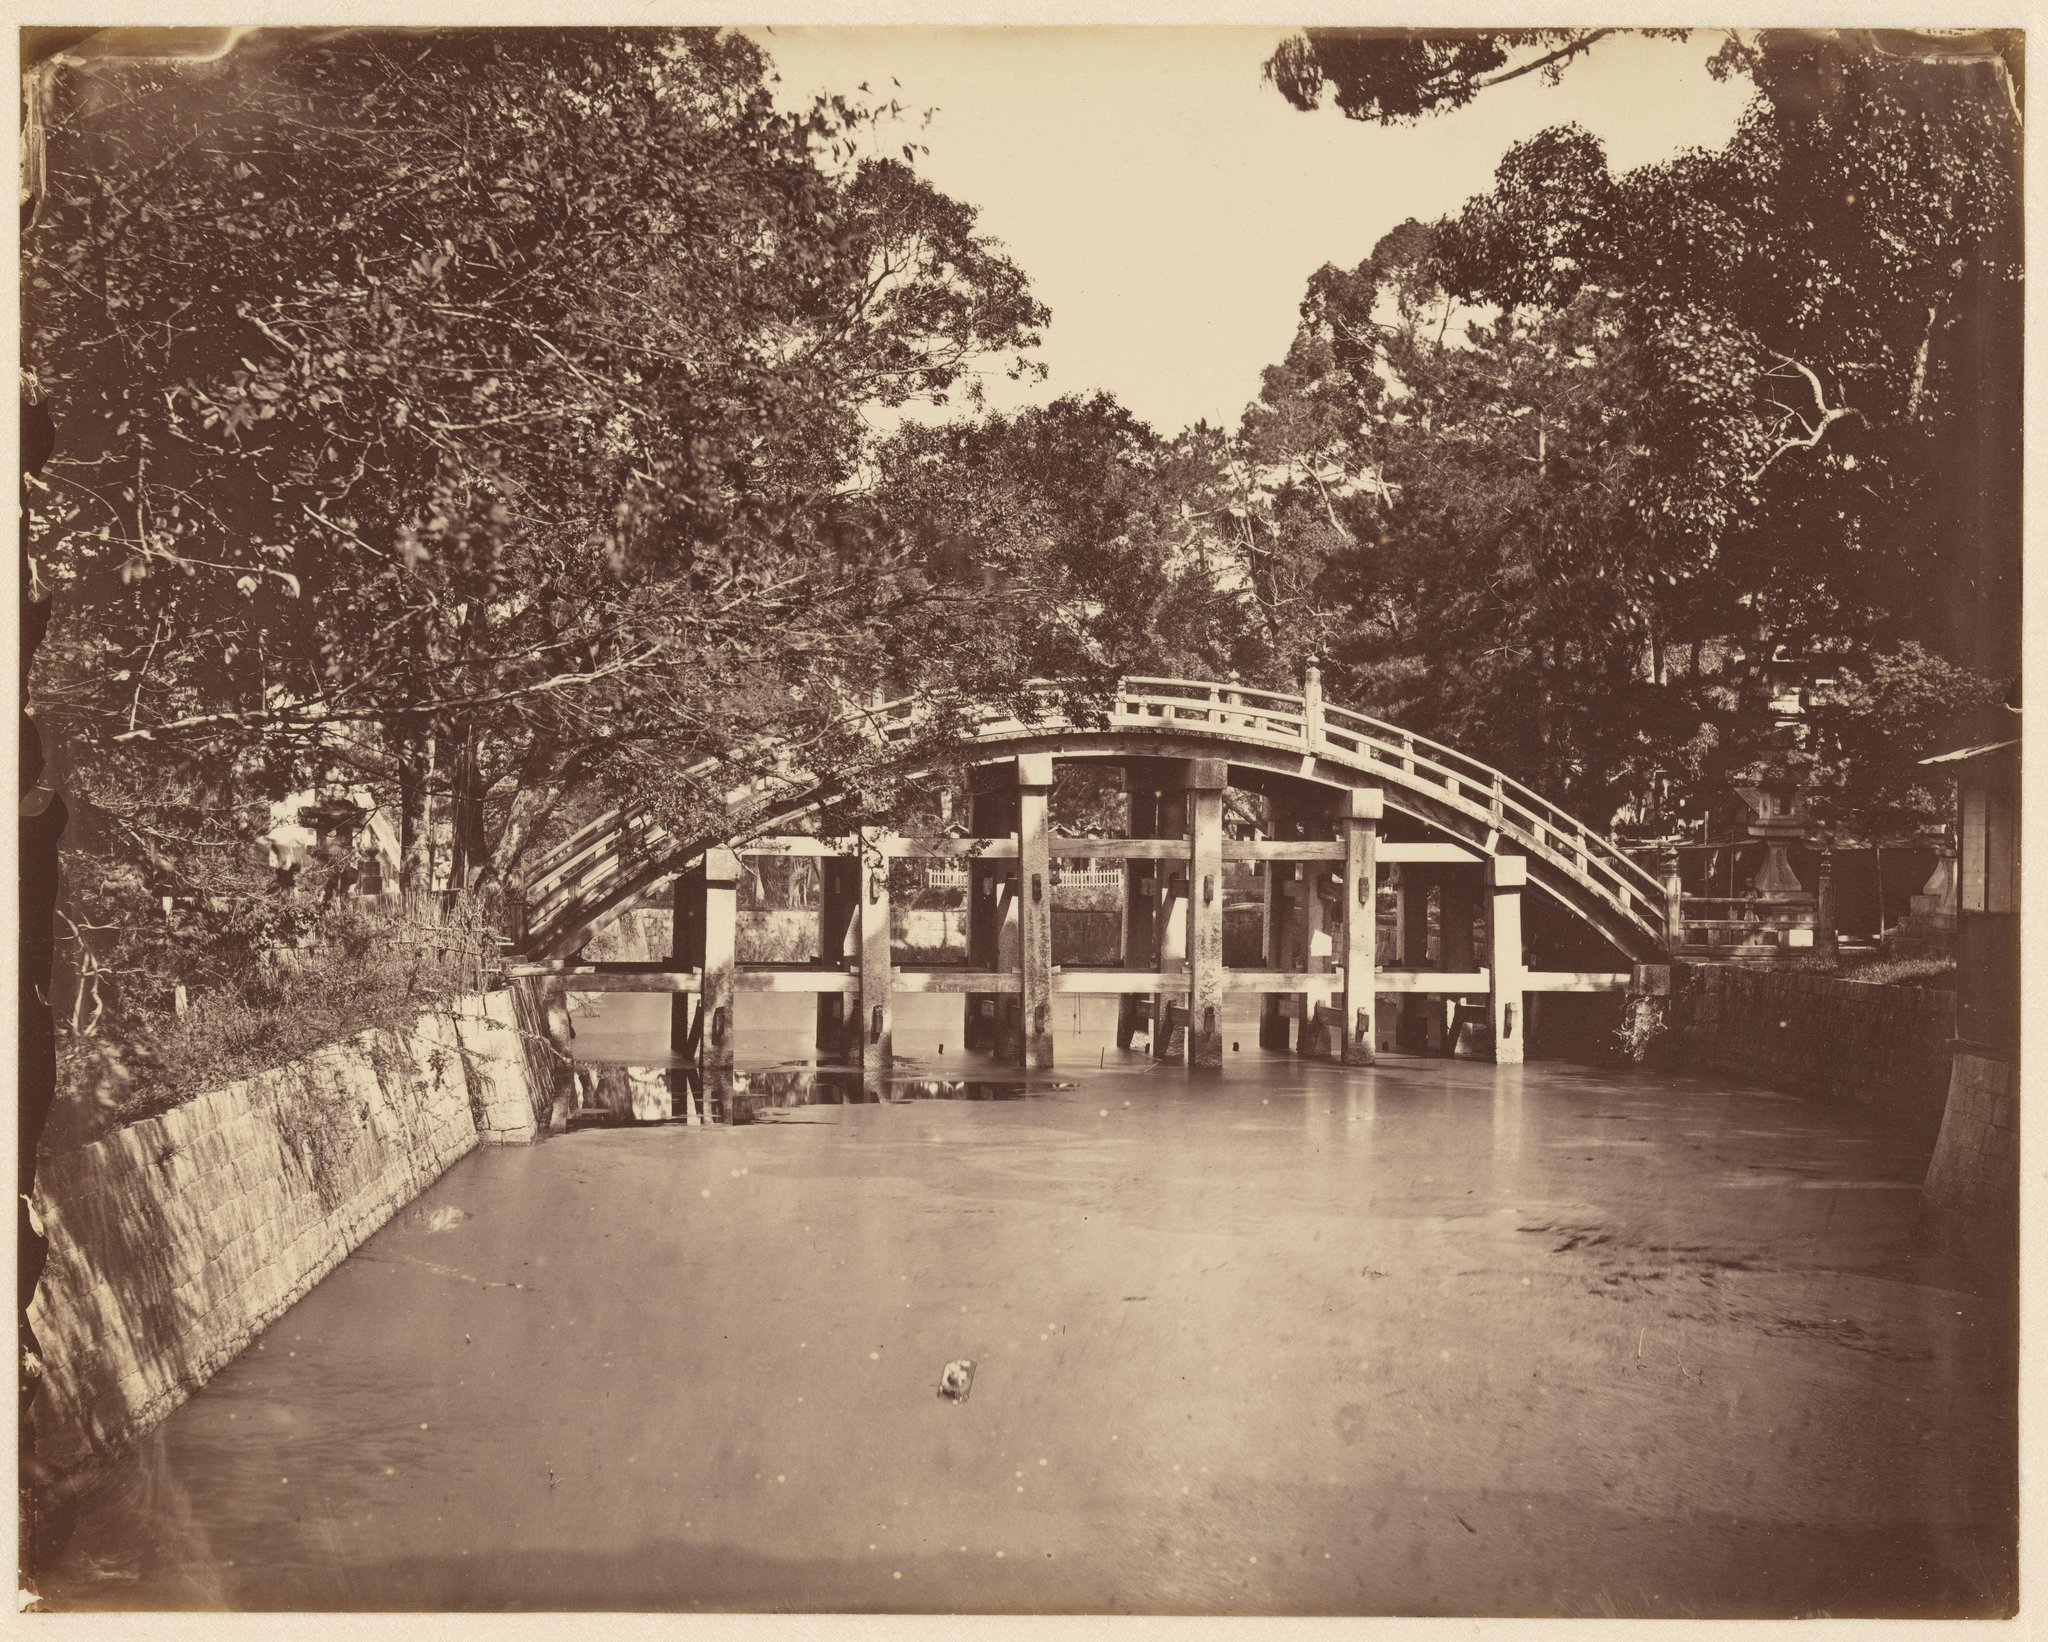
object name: photograph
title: Sorihashi bridge in Osaka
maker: Anonymous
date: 1865-1870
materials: paper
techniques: albumen print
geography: japan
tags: japan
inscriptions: inscription: ‘... nabij Osaka’, number: ‘M2’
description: This is one of the few photographs in the Bauduin collection with a title or description pencilled on the back: ‘Sumiyodi near Osaka’. Sorihashi bridge near the Sumiyoshi shrine is still a popular tourist site today. We do not know who added the title: Antoon or Albert, or perhaps their brother Dominique, who visited his brothers in Japan whilst touring Southeast Asia?